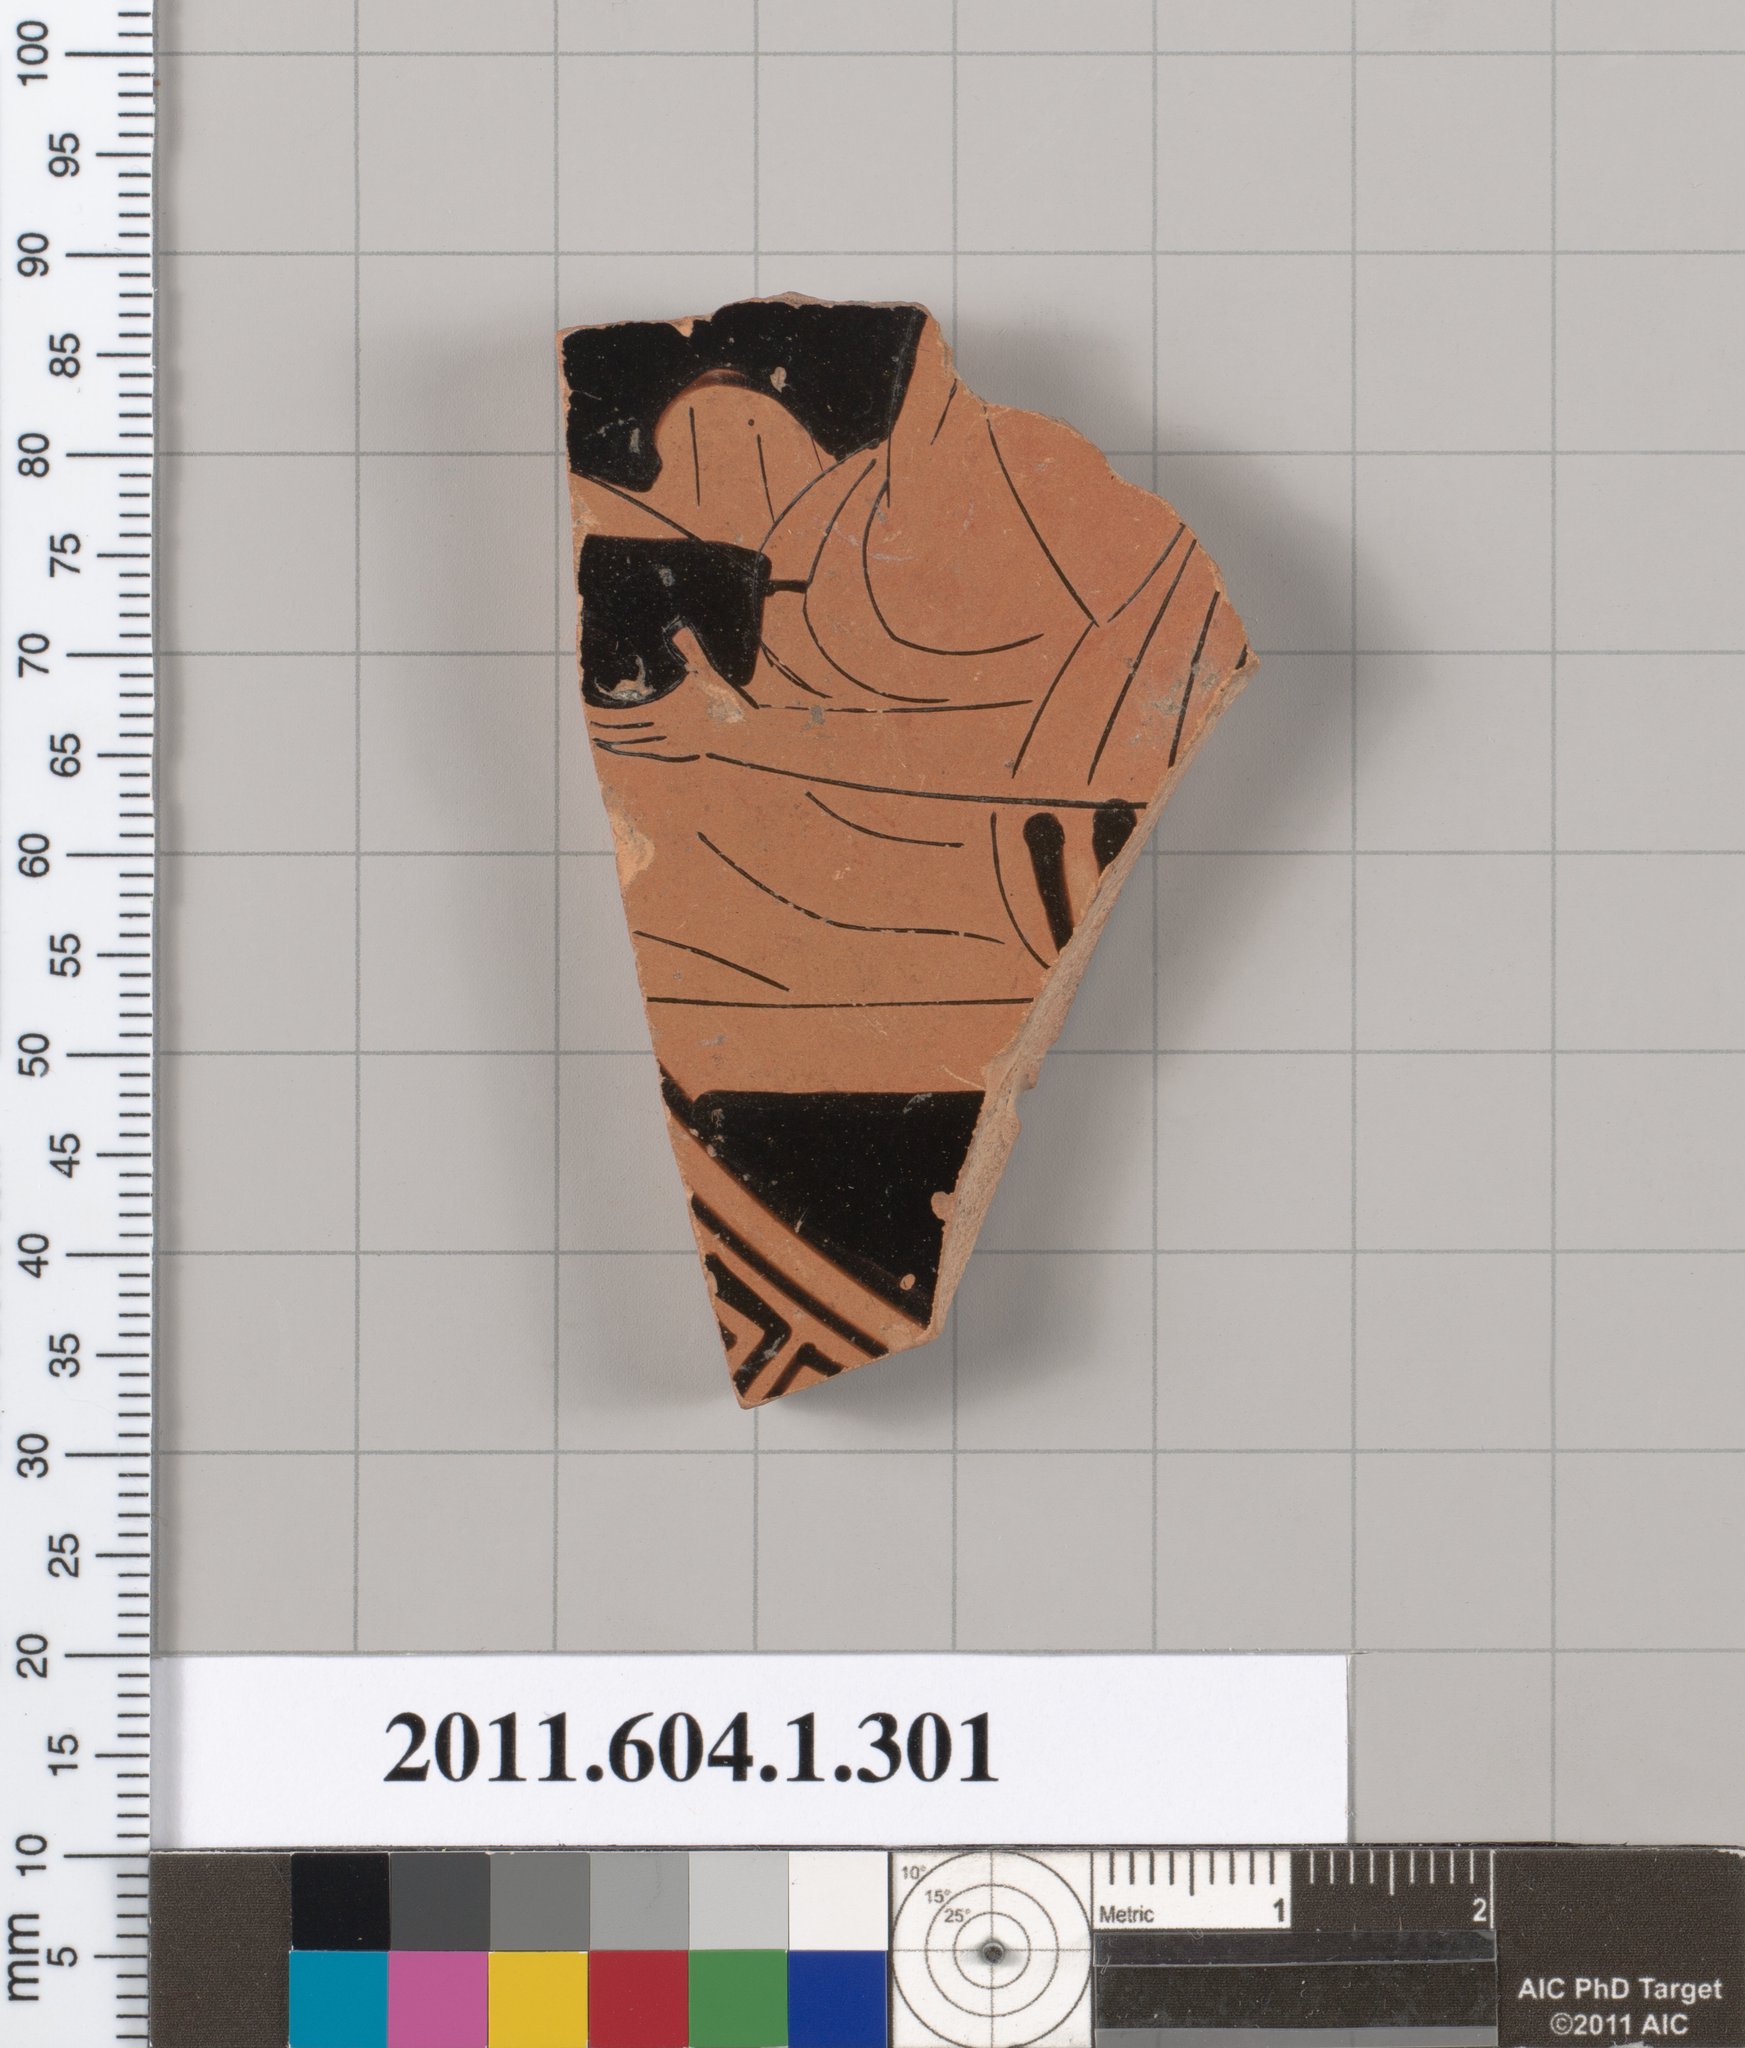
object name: kylix fragment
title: Terracotta fragment of a kylix (drinking cup)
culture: greek, attic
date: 475-451 BCE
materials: terracotta